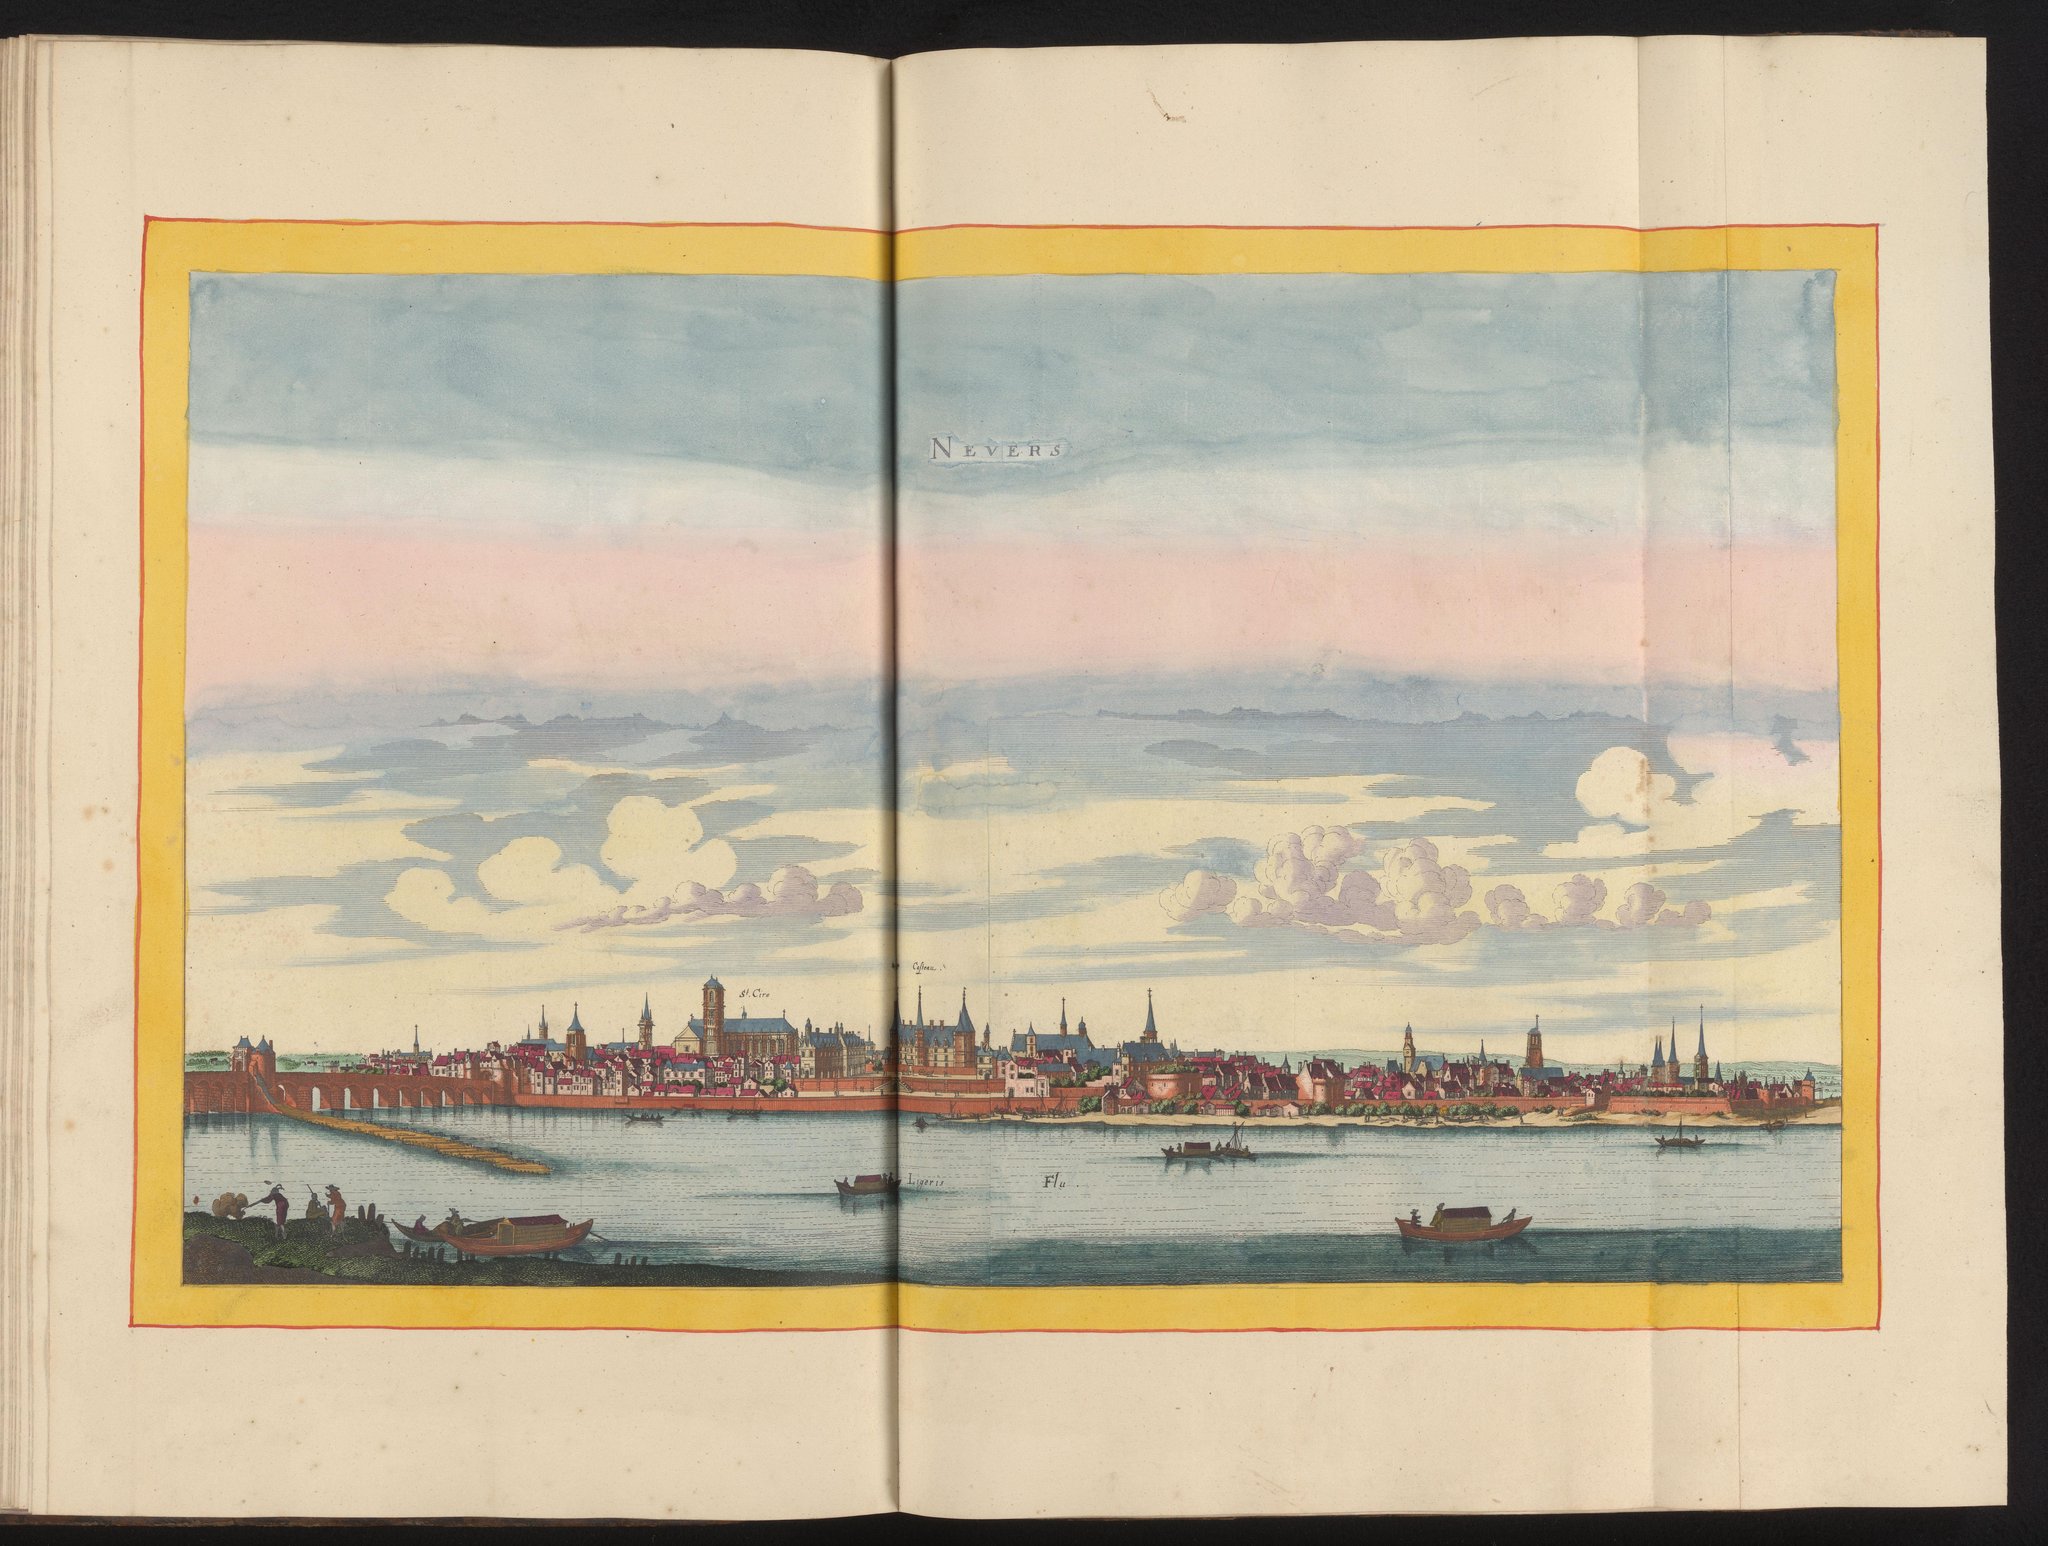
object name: print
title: Gezicht op Nevers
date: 1656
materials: paper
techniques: engraving, etching, hand coloring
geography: the hague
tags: city-view in general; 'veduta'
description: Prent uit: Zeiller, Martin. Topographia Galliae. 13 dln. Frankfurt: Caspar Merian, 1656, dl. 3, na p. 20.